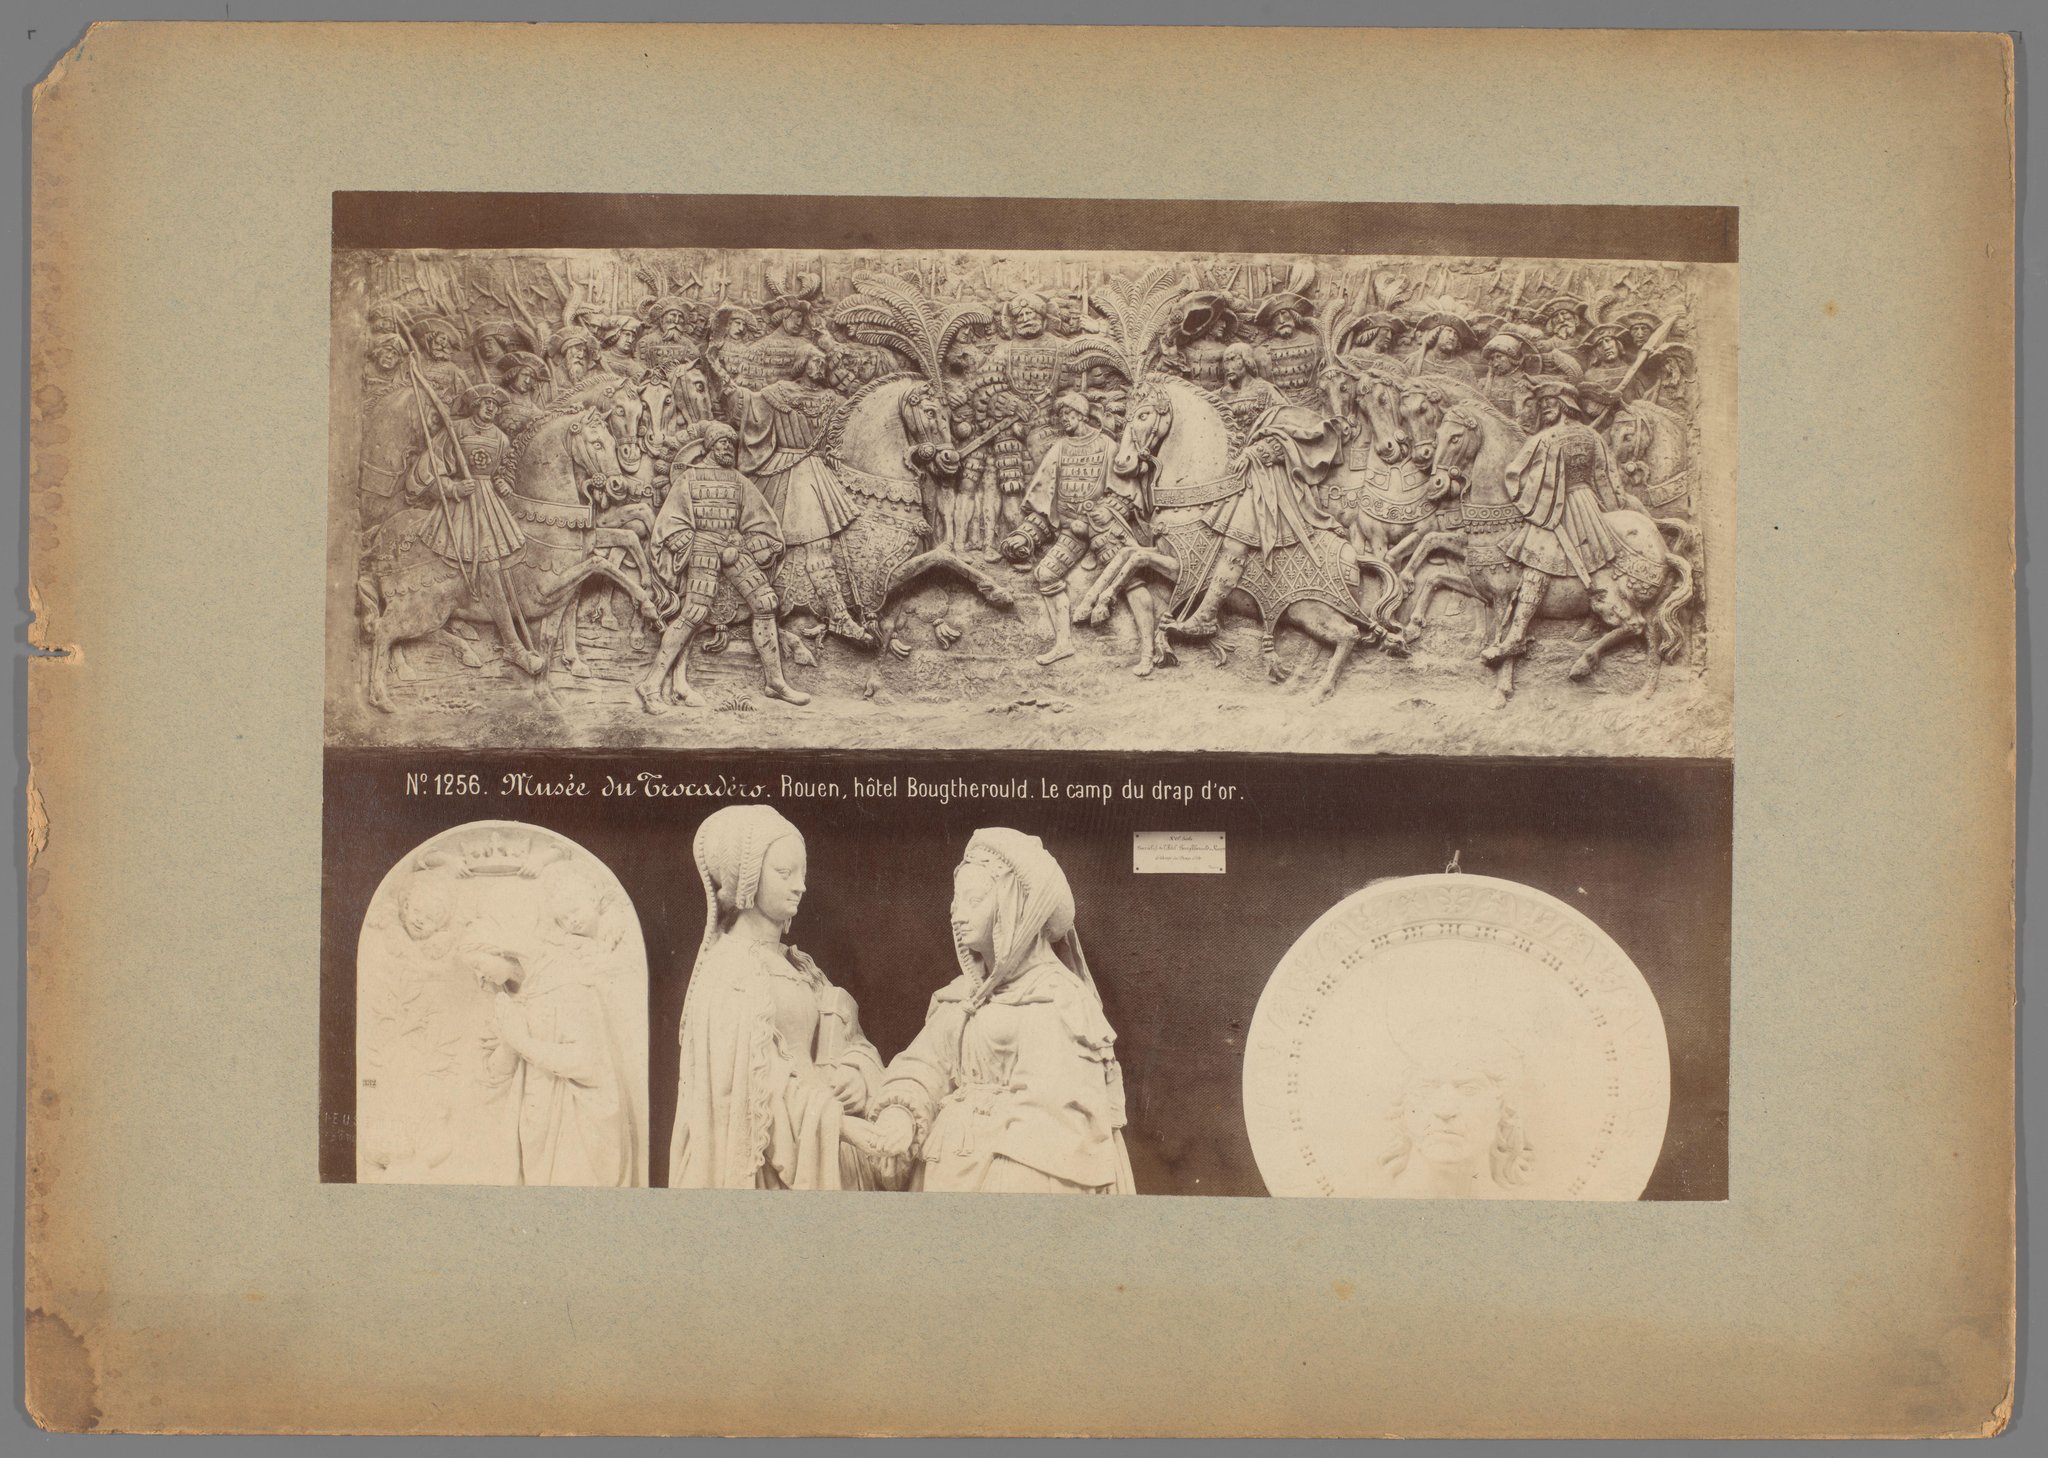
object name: photograph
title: Musée du Trocadéro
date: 1850-1900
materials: cardboard, photographic support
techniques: albumen print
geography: the hague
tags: sculpture, horse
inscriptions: inscription: ‘Rouen, hôtel de Bourgtherould.’, workshop stamp: ‘Kunsthandel/ J.A.G. de Leur/ Photograaf- Uitgever/ Huigenspark, 40b, [Den Haag]’, number: ‘1256’, collector's mark: ‘Rijks-normaalschool voor teekenonderwijzers Amsterdam’, check stamp: ‘[...]’